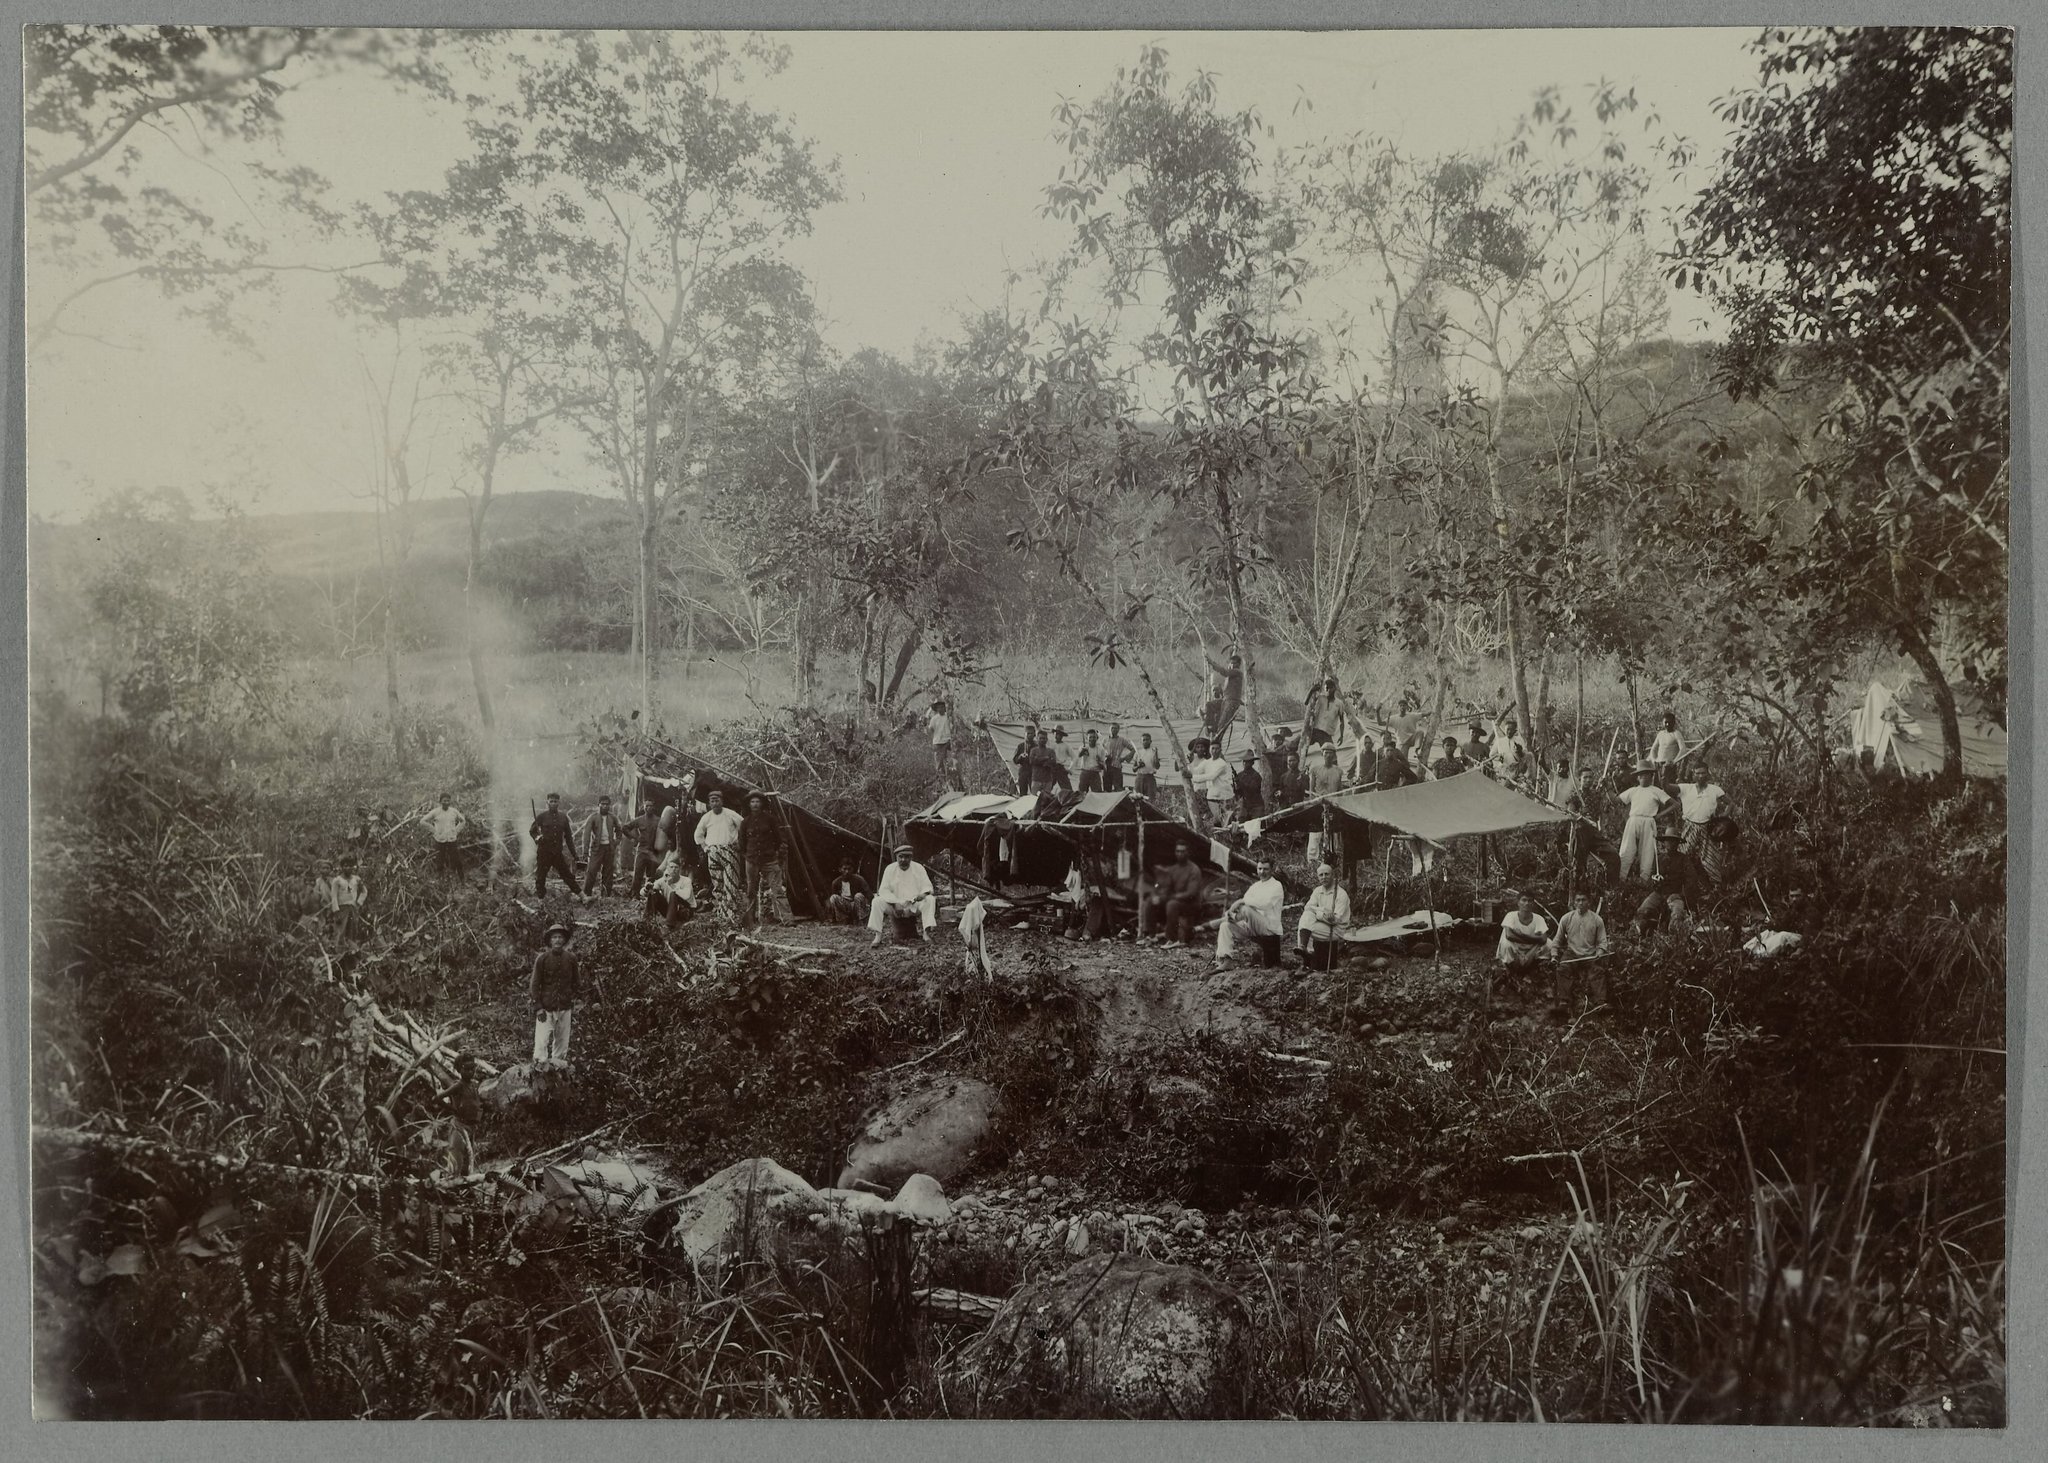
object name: photograph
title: Bosbivak bij Lampahan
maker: Anonymous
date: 1903-1913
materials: photographic support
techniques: photography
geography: north sumatra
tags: arnhem, the hague, albertus dominicus laman trip, landscapes in tropical and sub-tropical regions, road, path, camp-fire; watch-fire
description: Na de expedities naar de Gajo- en Alaslanden o.l.v. Van Daalen (eerste tocht in 1901), werd hij in 1903 belast met voorbereiding van permanente vestiging van Nederlands gezag. Aanleg van een weg van de Noordkust naar het binnenland was hierbij van groot belang. Deze zgn. Gajoweg werd aangelegd tussen 1903 en 1914, van Bireuen aan de kust naar Takinguen aan het bergmeer Danau Lauttawar, totale lente 104 km.